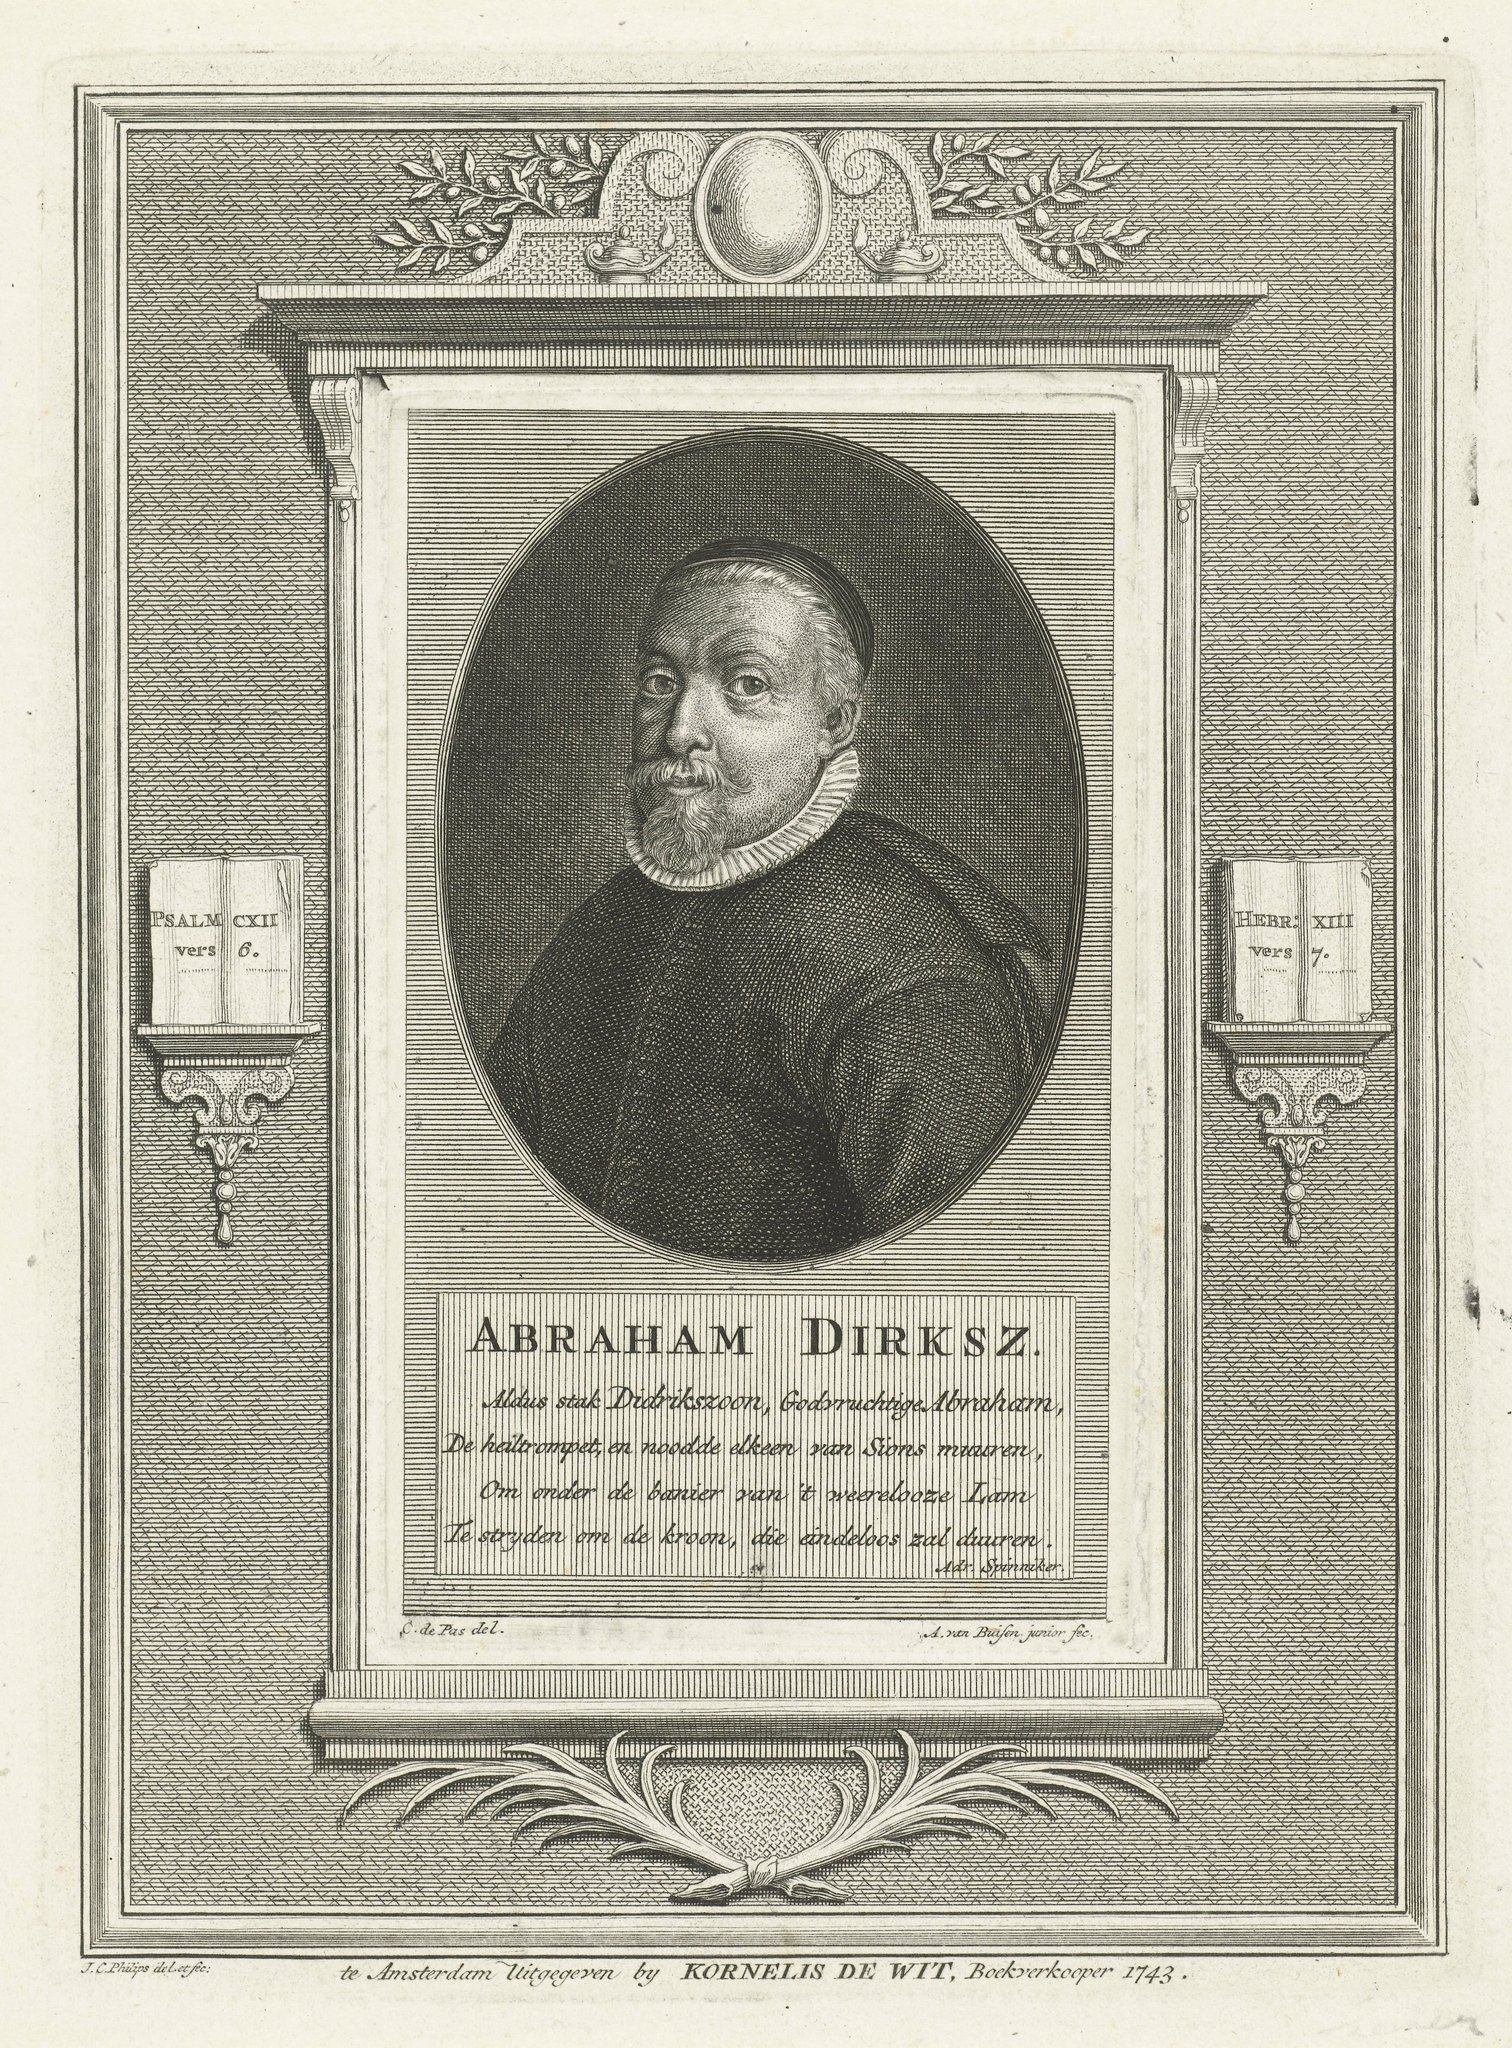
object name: print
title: Verzaameling van de afbeeldingen van veele voornaame mannen en leraaren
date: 1743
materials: paper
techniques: engraving, etching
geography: amsterdam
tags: organizational aspects ~ movements related with or derived from protestant churches, e.g.: christian science, mormons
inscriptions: collector's mark: Lugt 2166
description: Prent gedrukt van twee platen. Portret van de doopsgezinde predikant Abraham Dirks Bierens. Onder het portret een lofdicht van A. Spinniker. Rand gedrukt van een andere plaat met verwijzingen naar bijbelverzen en met palmbladeren versierd.